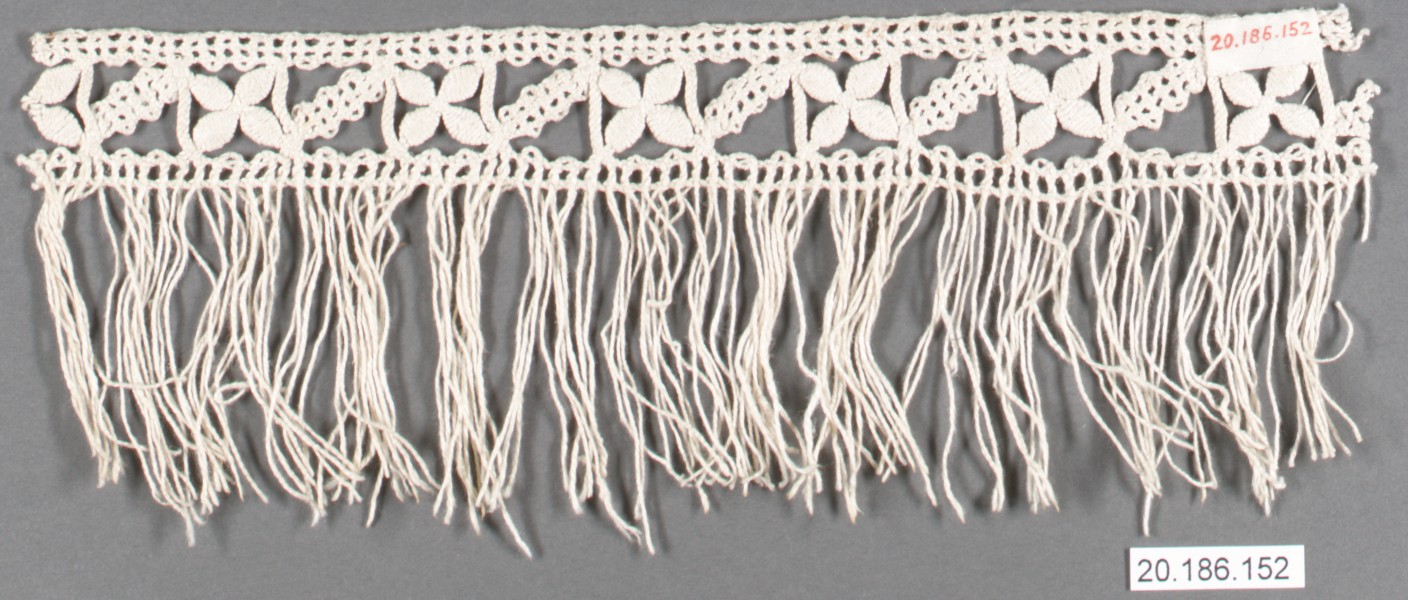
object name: edging with fringe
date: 1501-1600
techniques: lace